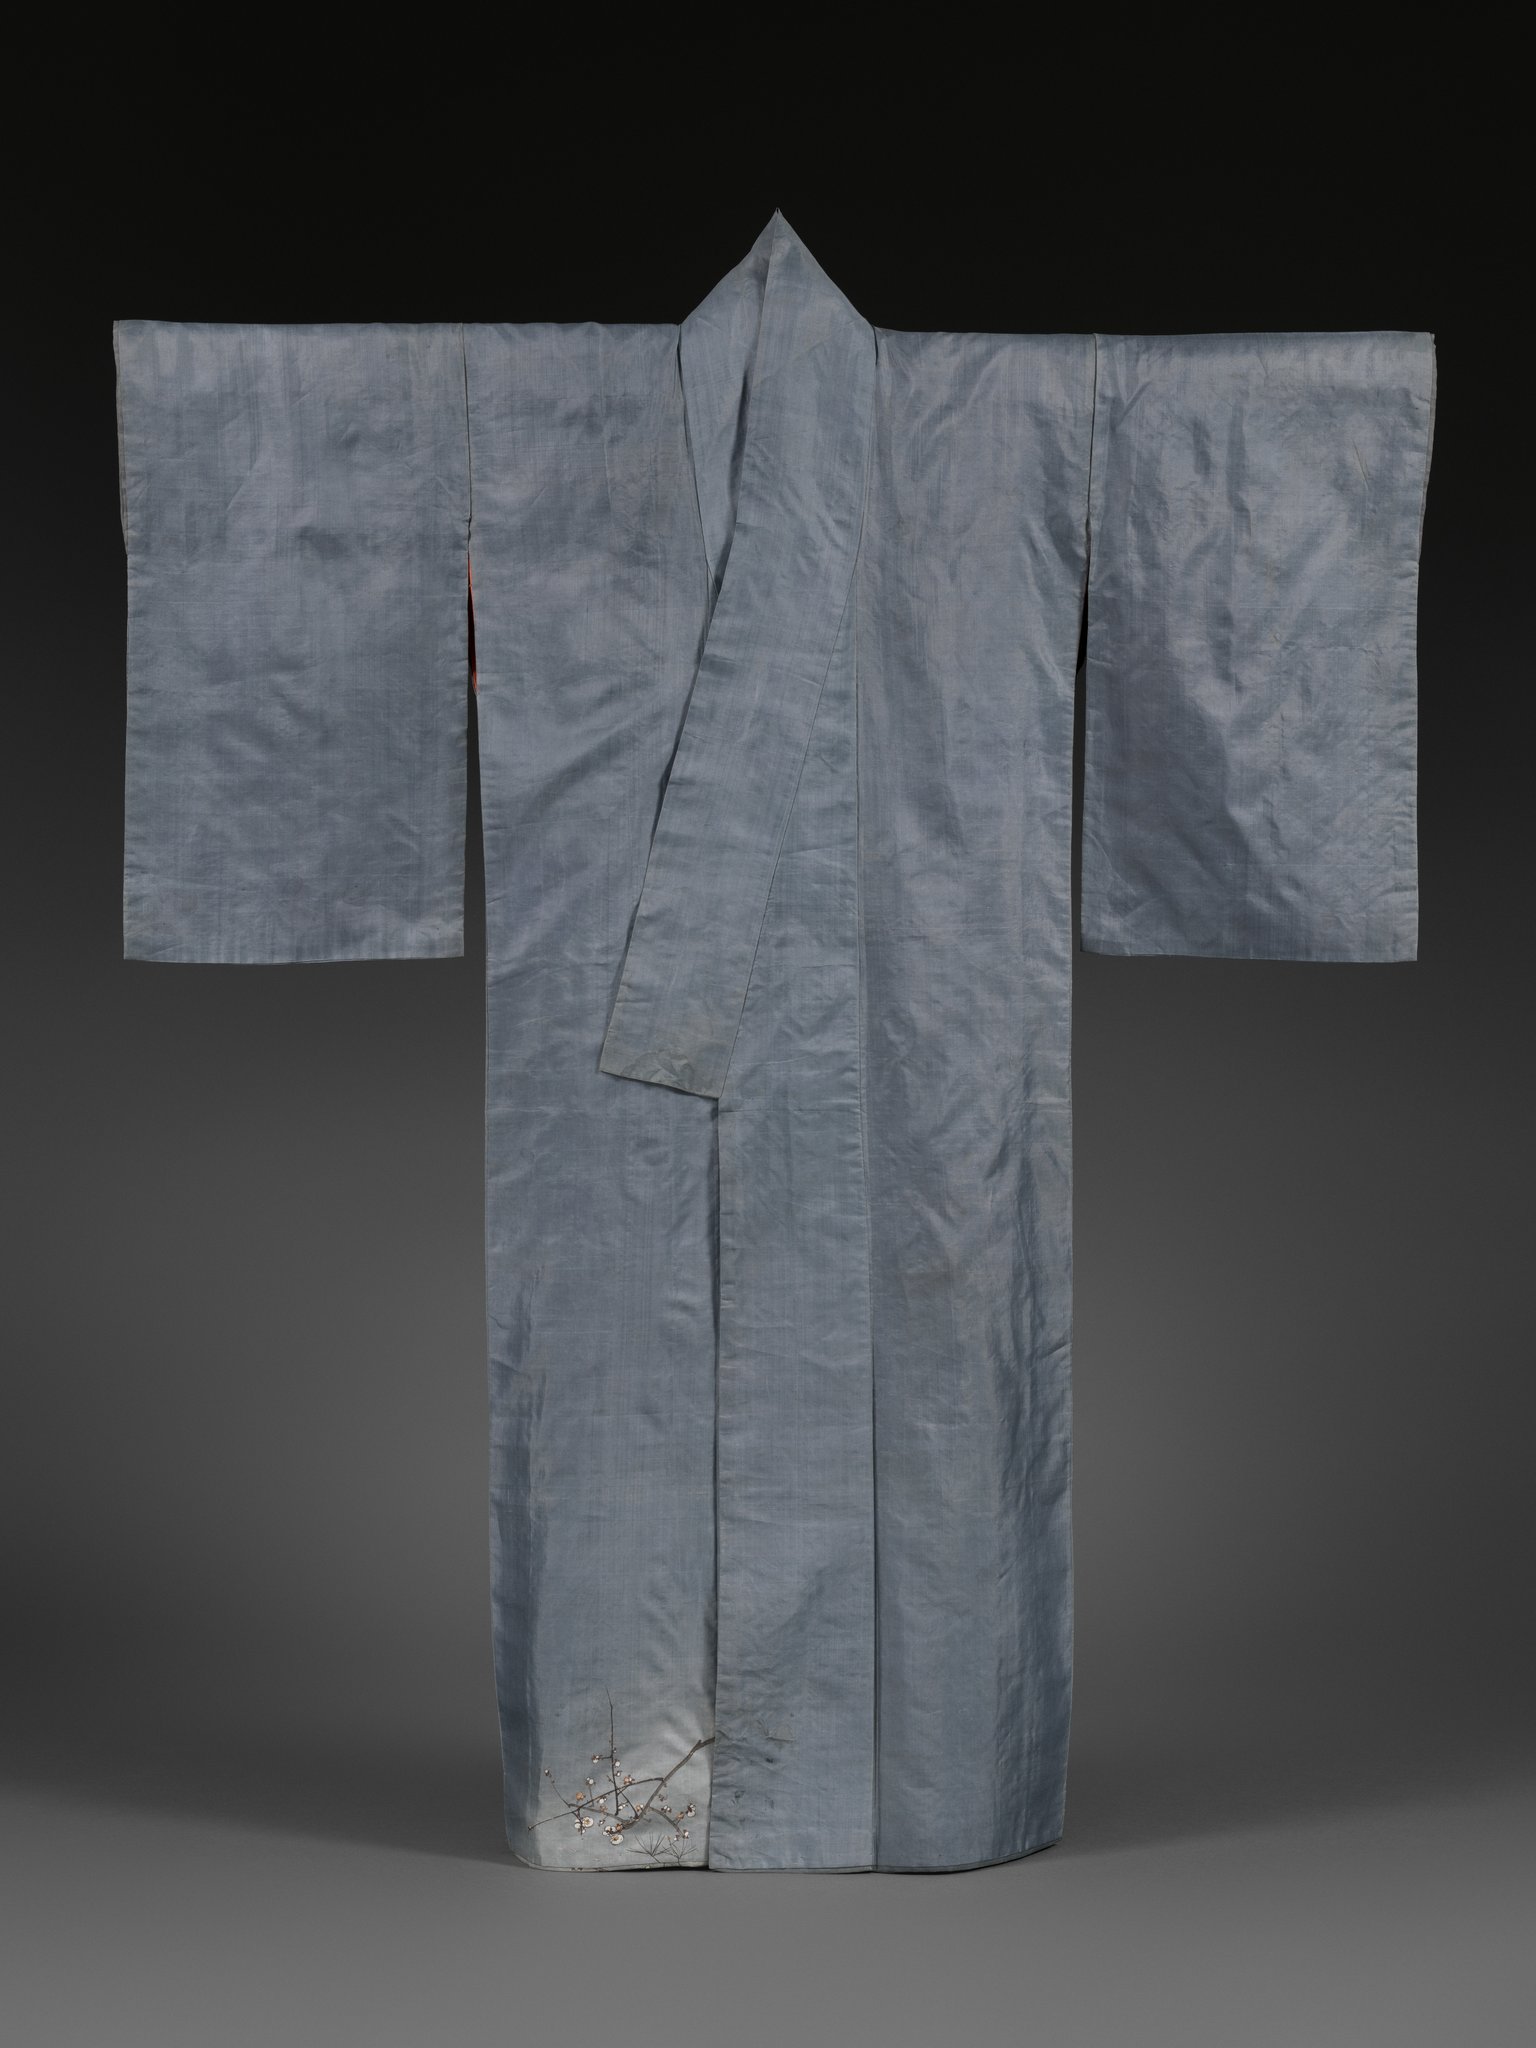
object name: kimono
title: Kimono with Blossoming Plum Tree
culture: japanese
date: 1851-1900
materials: ink, metal thread, pigment, silk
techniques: embroidery, weave, resist